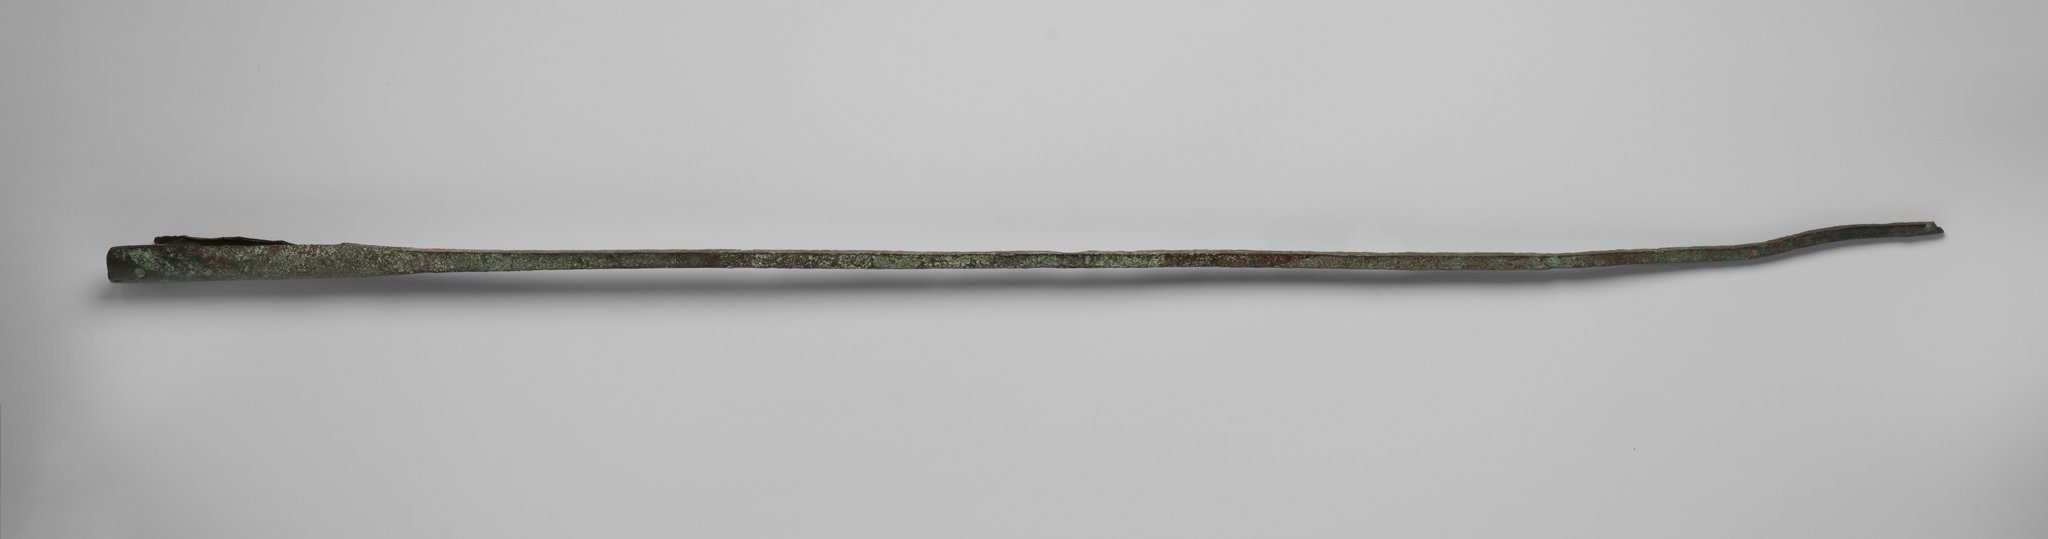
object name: spearhead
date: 7000 BCE-330 CE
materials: bronze